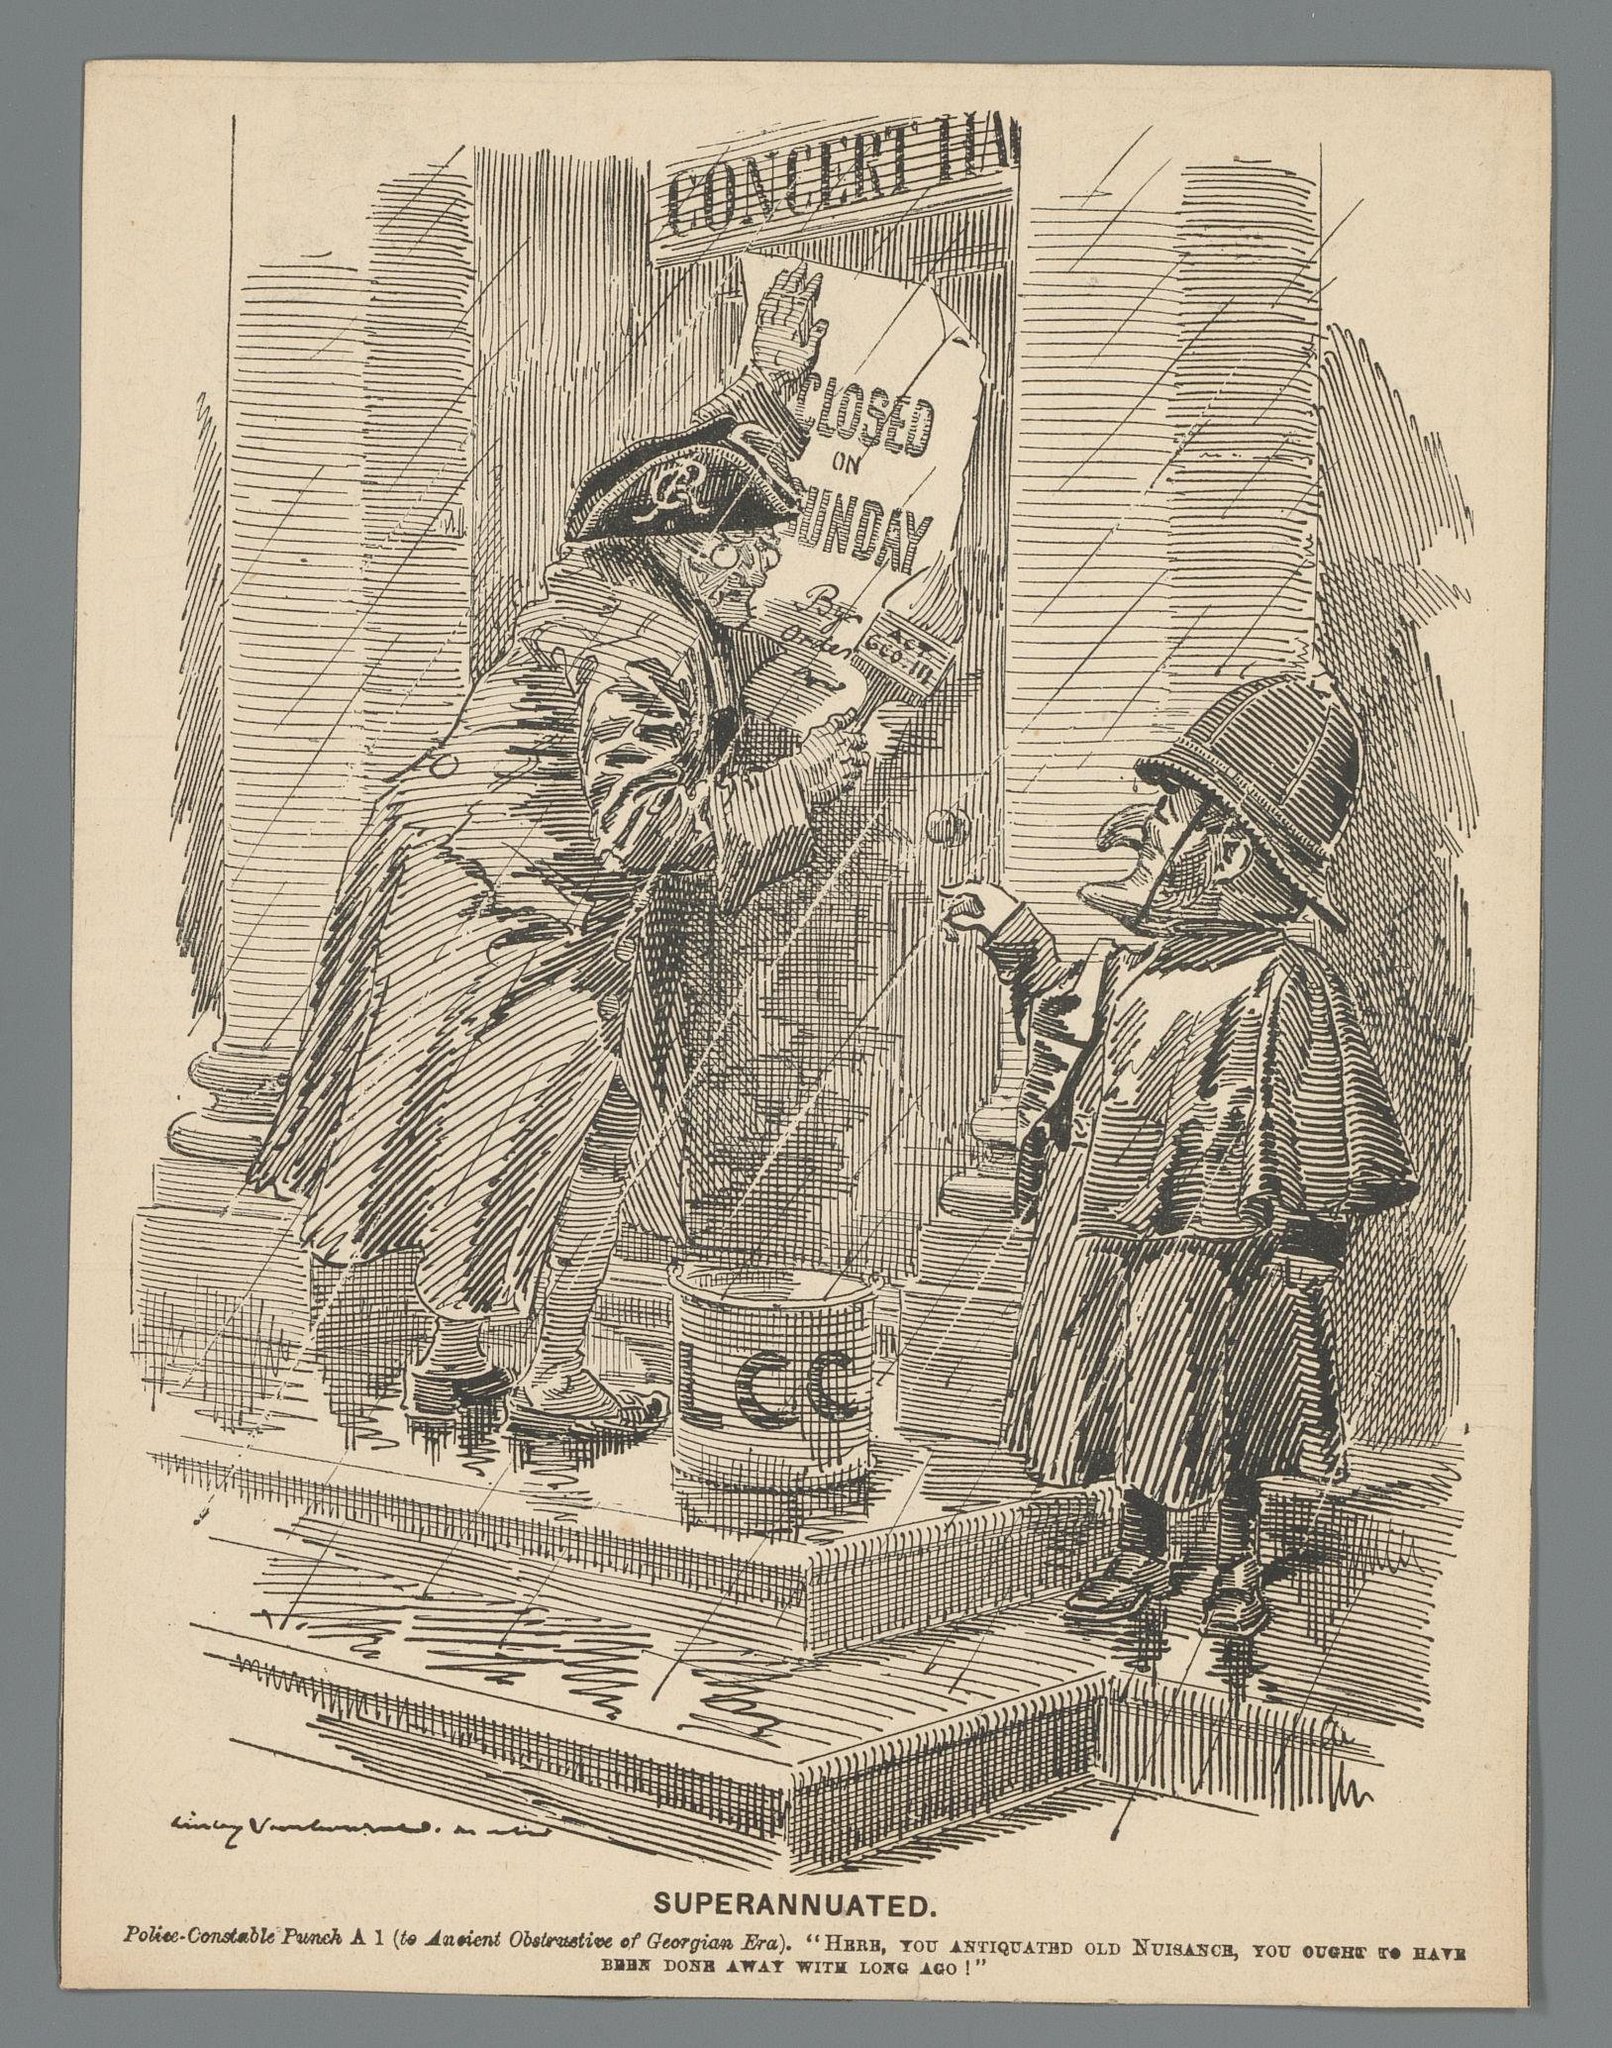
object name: cartoon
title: Politieagent Punch spreekt een oude man aan die een affiche aan een deur plakt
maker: edward linley sambourne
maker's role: draughtsman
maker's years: 1844-1910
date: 1898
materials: paper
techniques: line block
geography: england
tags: policeman, constable, advertisement, notice, political caricatures and satires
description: Politieagent Punch spreekt een oude man aan die een affiche aan een deur plakt over het sluiten van de concertzaal. Politieke spotprent uit het Engelse satirische tijdschrift Punch, 1898.